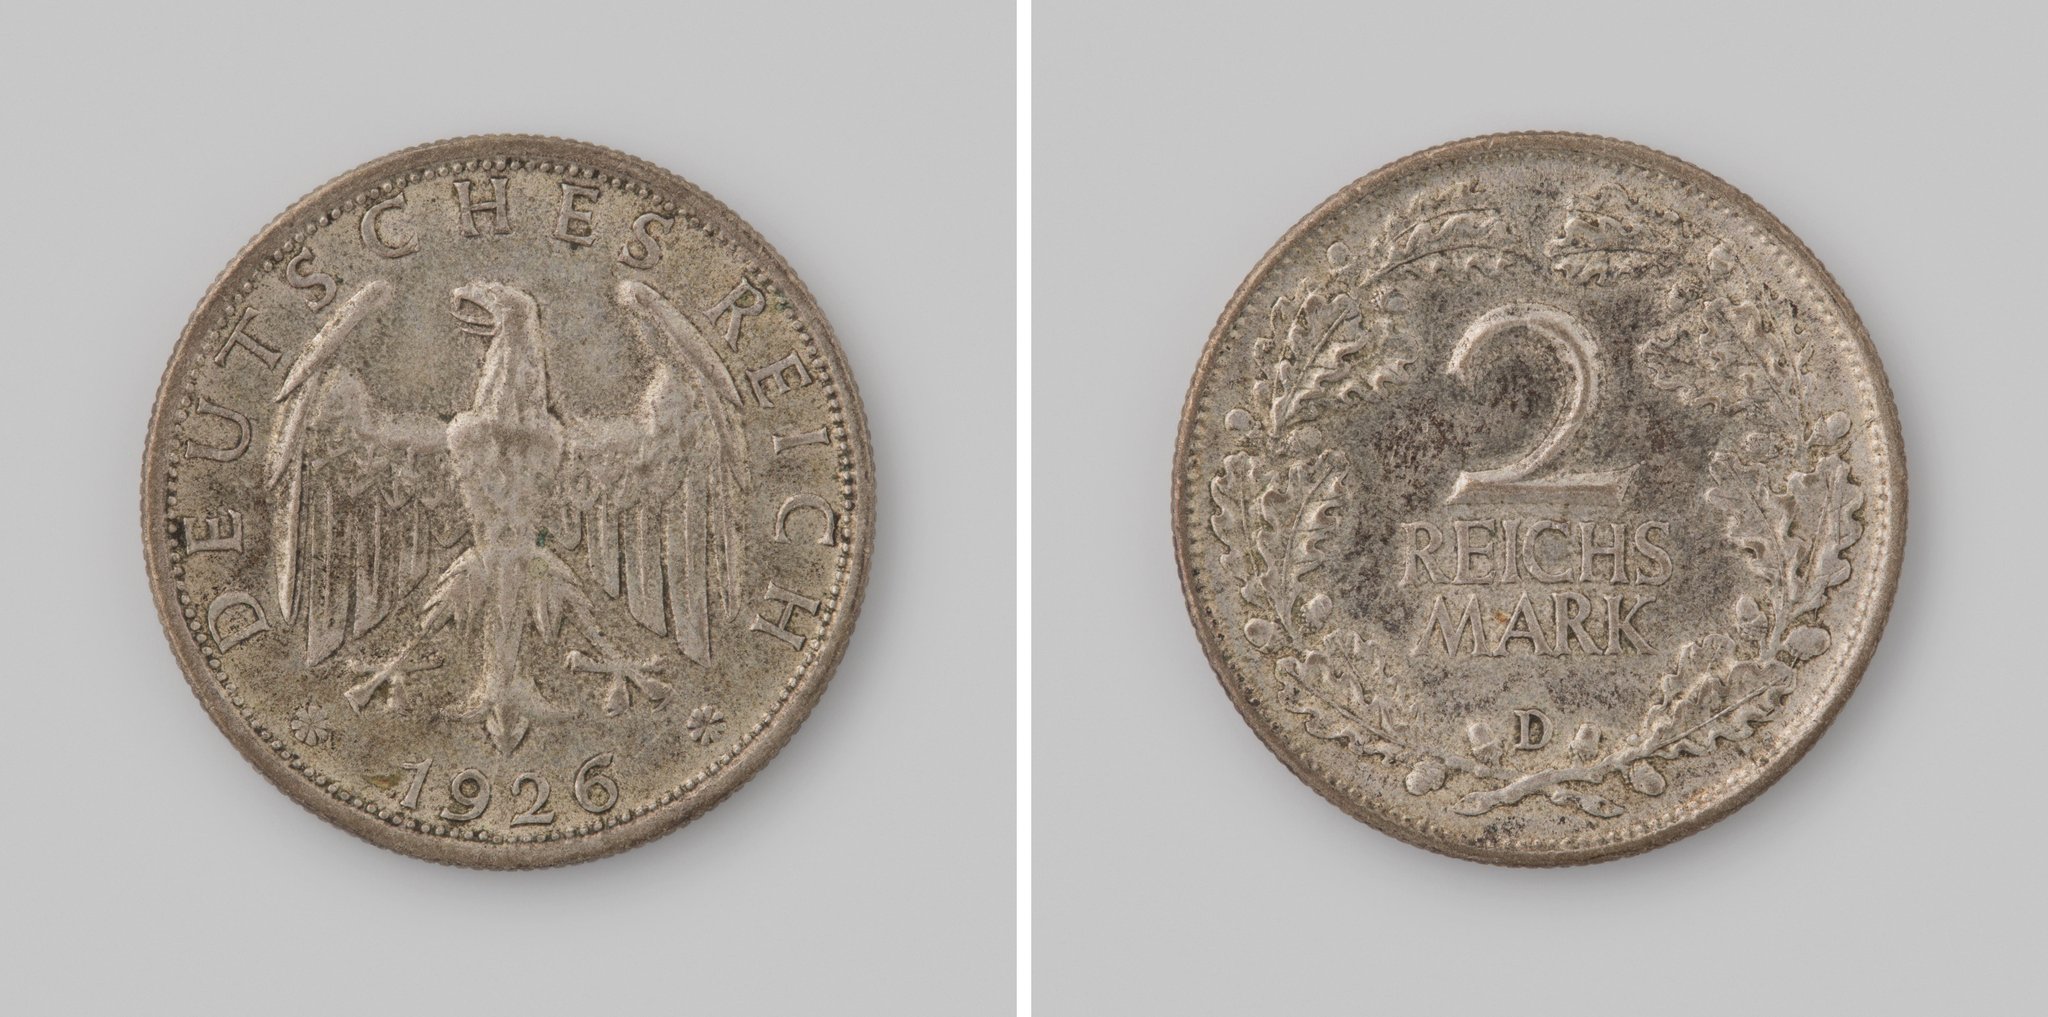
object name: coin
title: 2 Reichsmark uit Duitsland, 1926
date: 1926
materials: silver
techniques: striking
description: Zilveren munt. Voorzijde: enkelkoppige adelaar naar links. Jaartal onderaan. Keerzijde: binnen twee samengebonden eiketakken waarde-aanduiding in twee regels, waaronder letter D. Geslagen te München. Kartelrand.